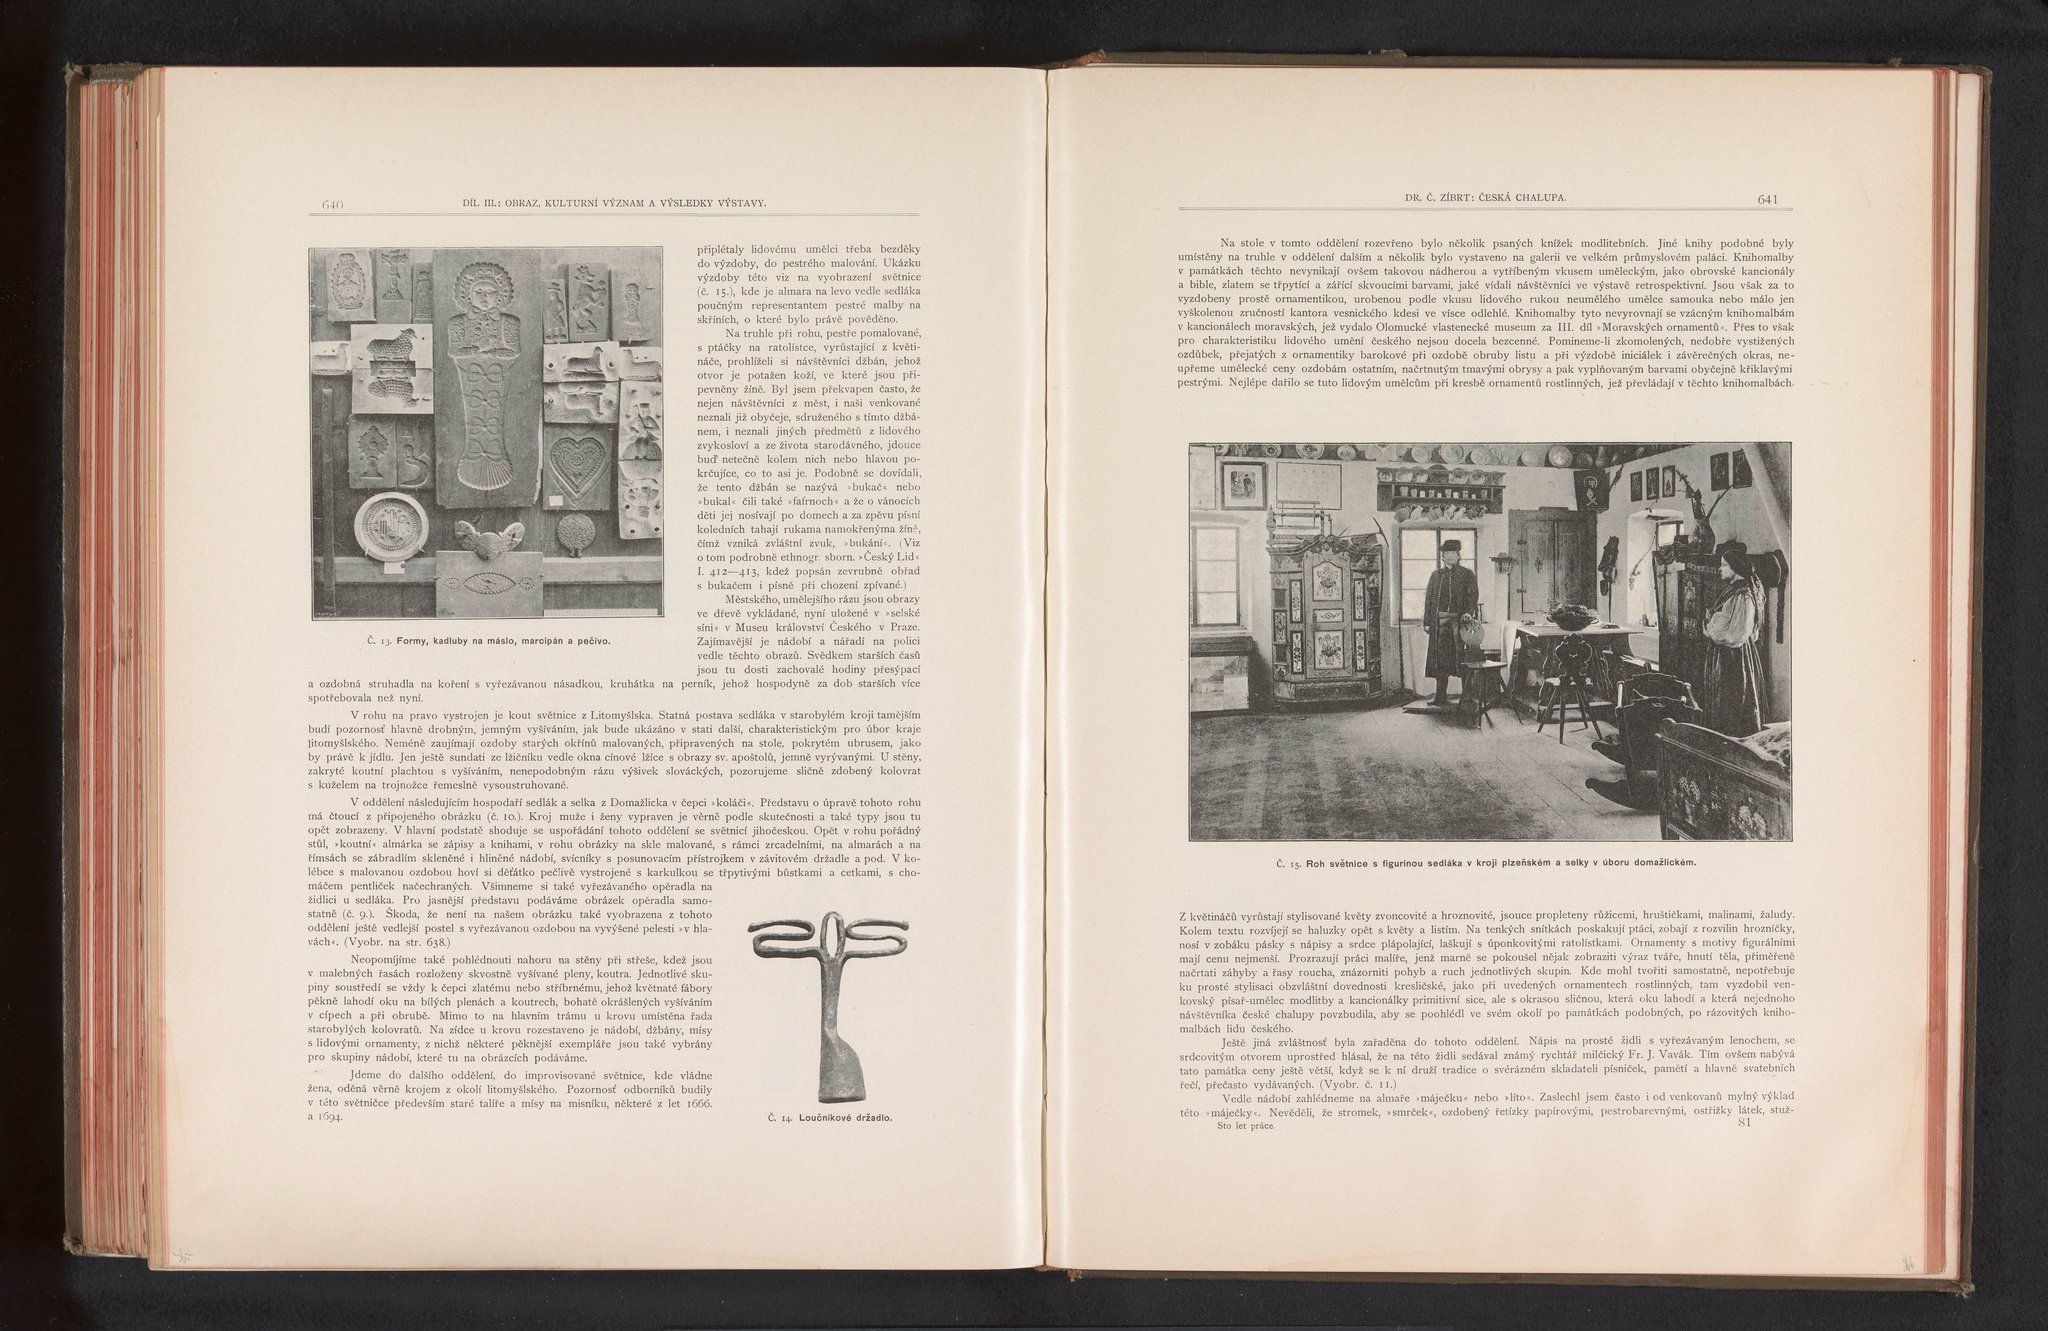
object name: page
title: Roh svetnice s figurinou sedláka v kroji plzenském v úboru domazlickem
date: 1891-1895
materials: paper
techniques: autotype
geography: prague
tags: farmers, folk costume, regional costume, interior ~ representation of a building